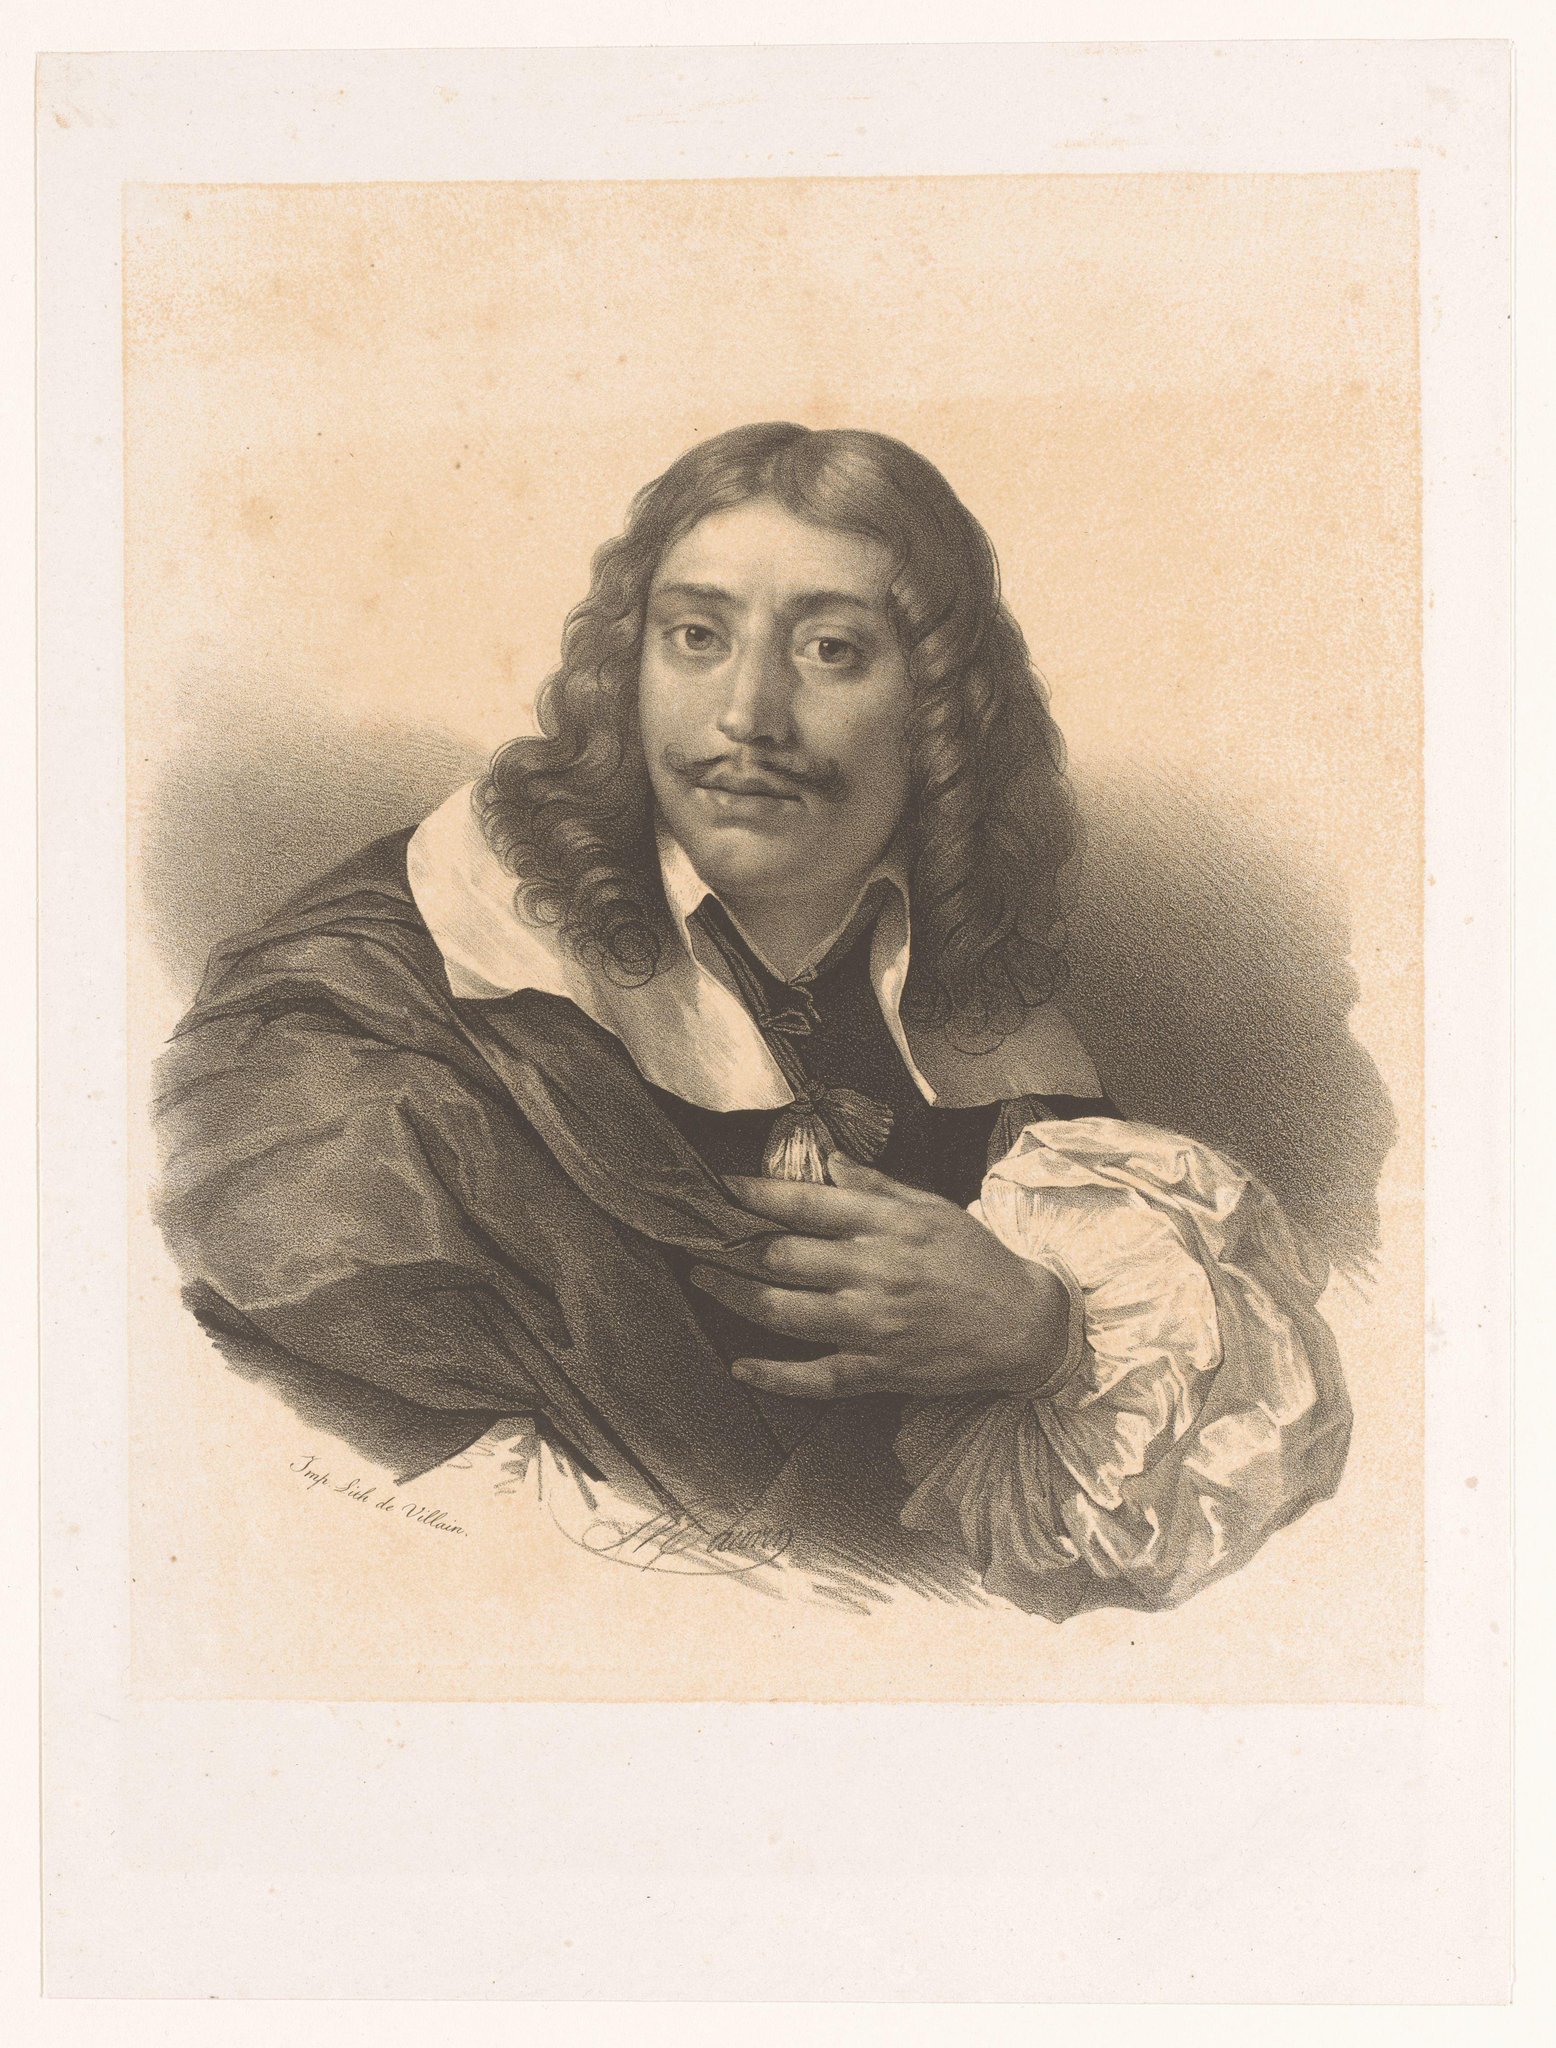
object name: print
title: Portret van Karel du Jardin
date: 1826-1852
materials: paper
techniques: tone lithography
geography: paris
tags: amsterdam, venice, painter, print maker, draughtsman, karel du jardin, historical persons, portrait, self-portrait of painter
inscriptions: collector's mark: Lugt 2760, inscription: ‘Copie v/d zelfde zijde/ Lith door C.C.A. Last/ Dezelfde grootte steen druk van Portman’, collector's mark: Lugt 2228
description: Prent ook gebruikt in: Chabert, Jean Claude. Galerie des peintres ou collection de portraits des peintres les plus célèbres de toutes les écoles. Accompagnée d'une notice sur chacun d'eux, et de copies de dessins originaux / Galerie des peintres ou collection de portraits des peintres les plus célèbres de toutes les écoles. Accompagnée de leur notice historique, de leurs dessins et d'un discours sur les arts. Parijs: Jean Claude Chabert, s.a. [1822-1834]. De samenstelling van tegenwoordig bekende en al dan niet gebonden exemplaren van deze uitgave verschillen. Dit omdat de prenten en bijhorende stukken tekst op inschrijving en waarschijnlijk ook los verkrijgbaar waren.